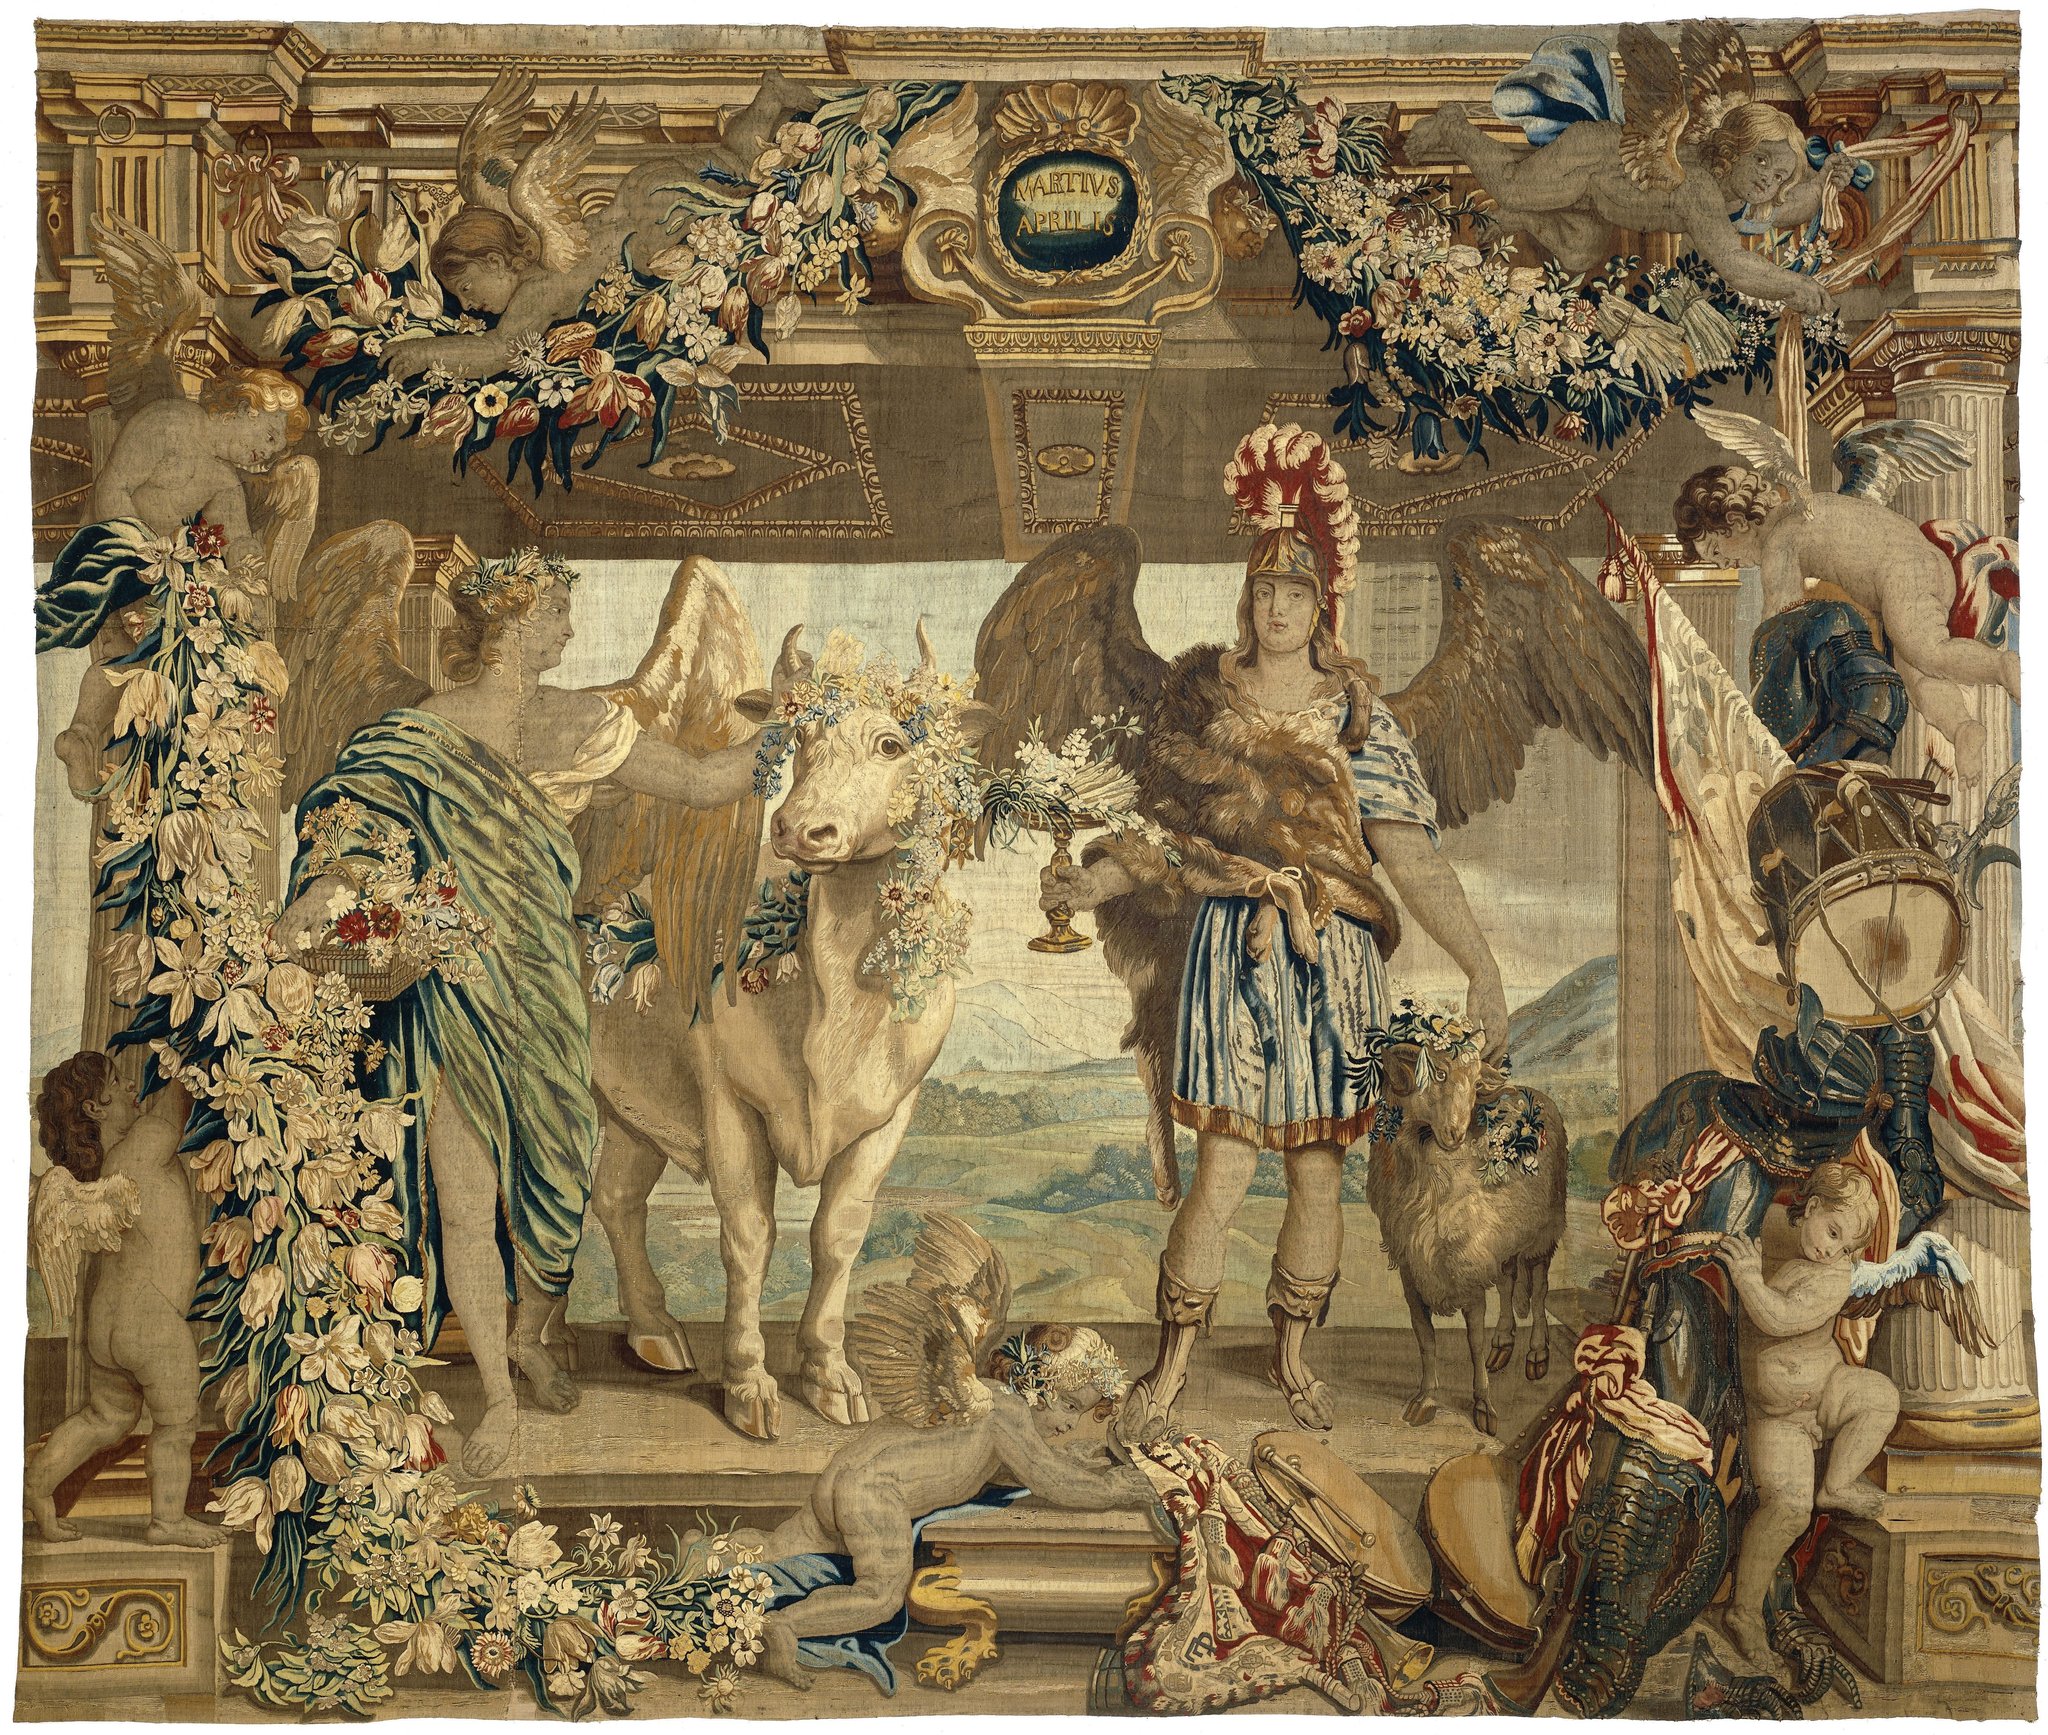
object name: tapestry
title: De maanden, seizoenen, elementen, dag en nacht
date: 1650-1680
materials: metal thread, silk, wool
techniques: tapestry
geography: brussels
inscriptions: monogram: ‘L.G.’, inscription: ‘MARTIVS // APRILIS’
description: Wandtapijt met een allegorische voorstelling van de maand maart en de maand april, uit een serie van tien voorstellende de maanden jaargetijden en elementen, binnen een architectuarale omlijsting.